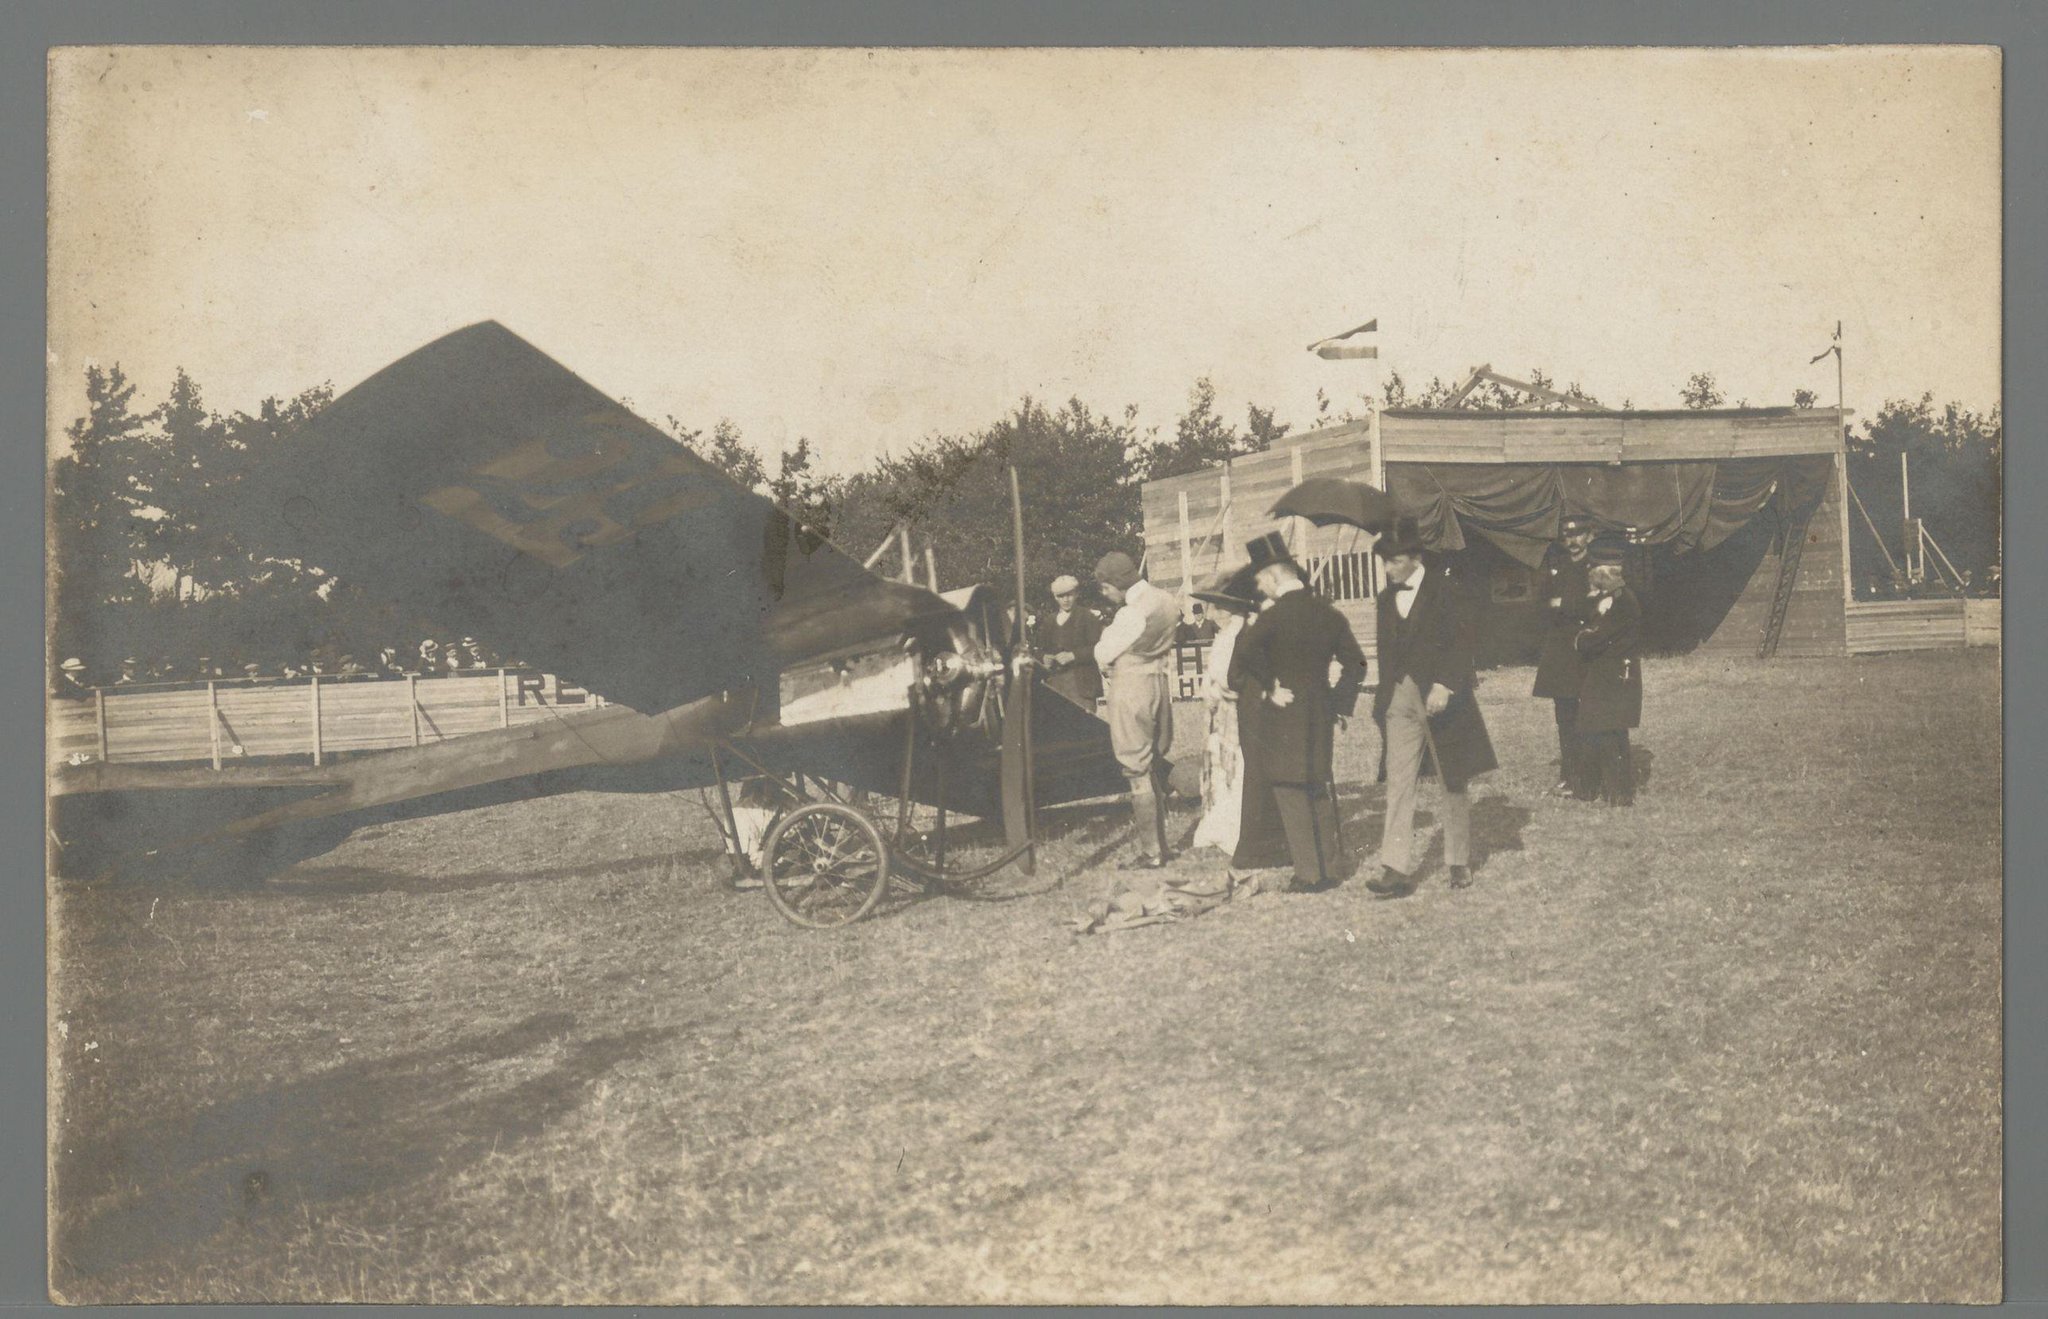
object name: ansichtkaart, prentbriefkaart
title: Staand gezelschap rond een stilstaand propellorvliegtuig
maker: Anonymous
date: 1905-1930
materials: photographic support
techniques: photography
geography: amsterdam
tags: aircraft, aeroplane, adult man (+ seven persons)